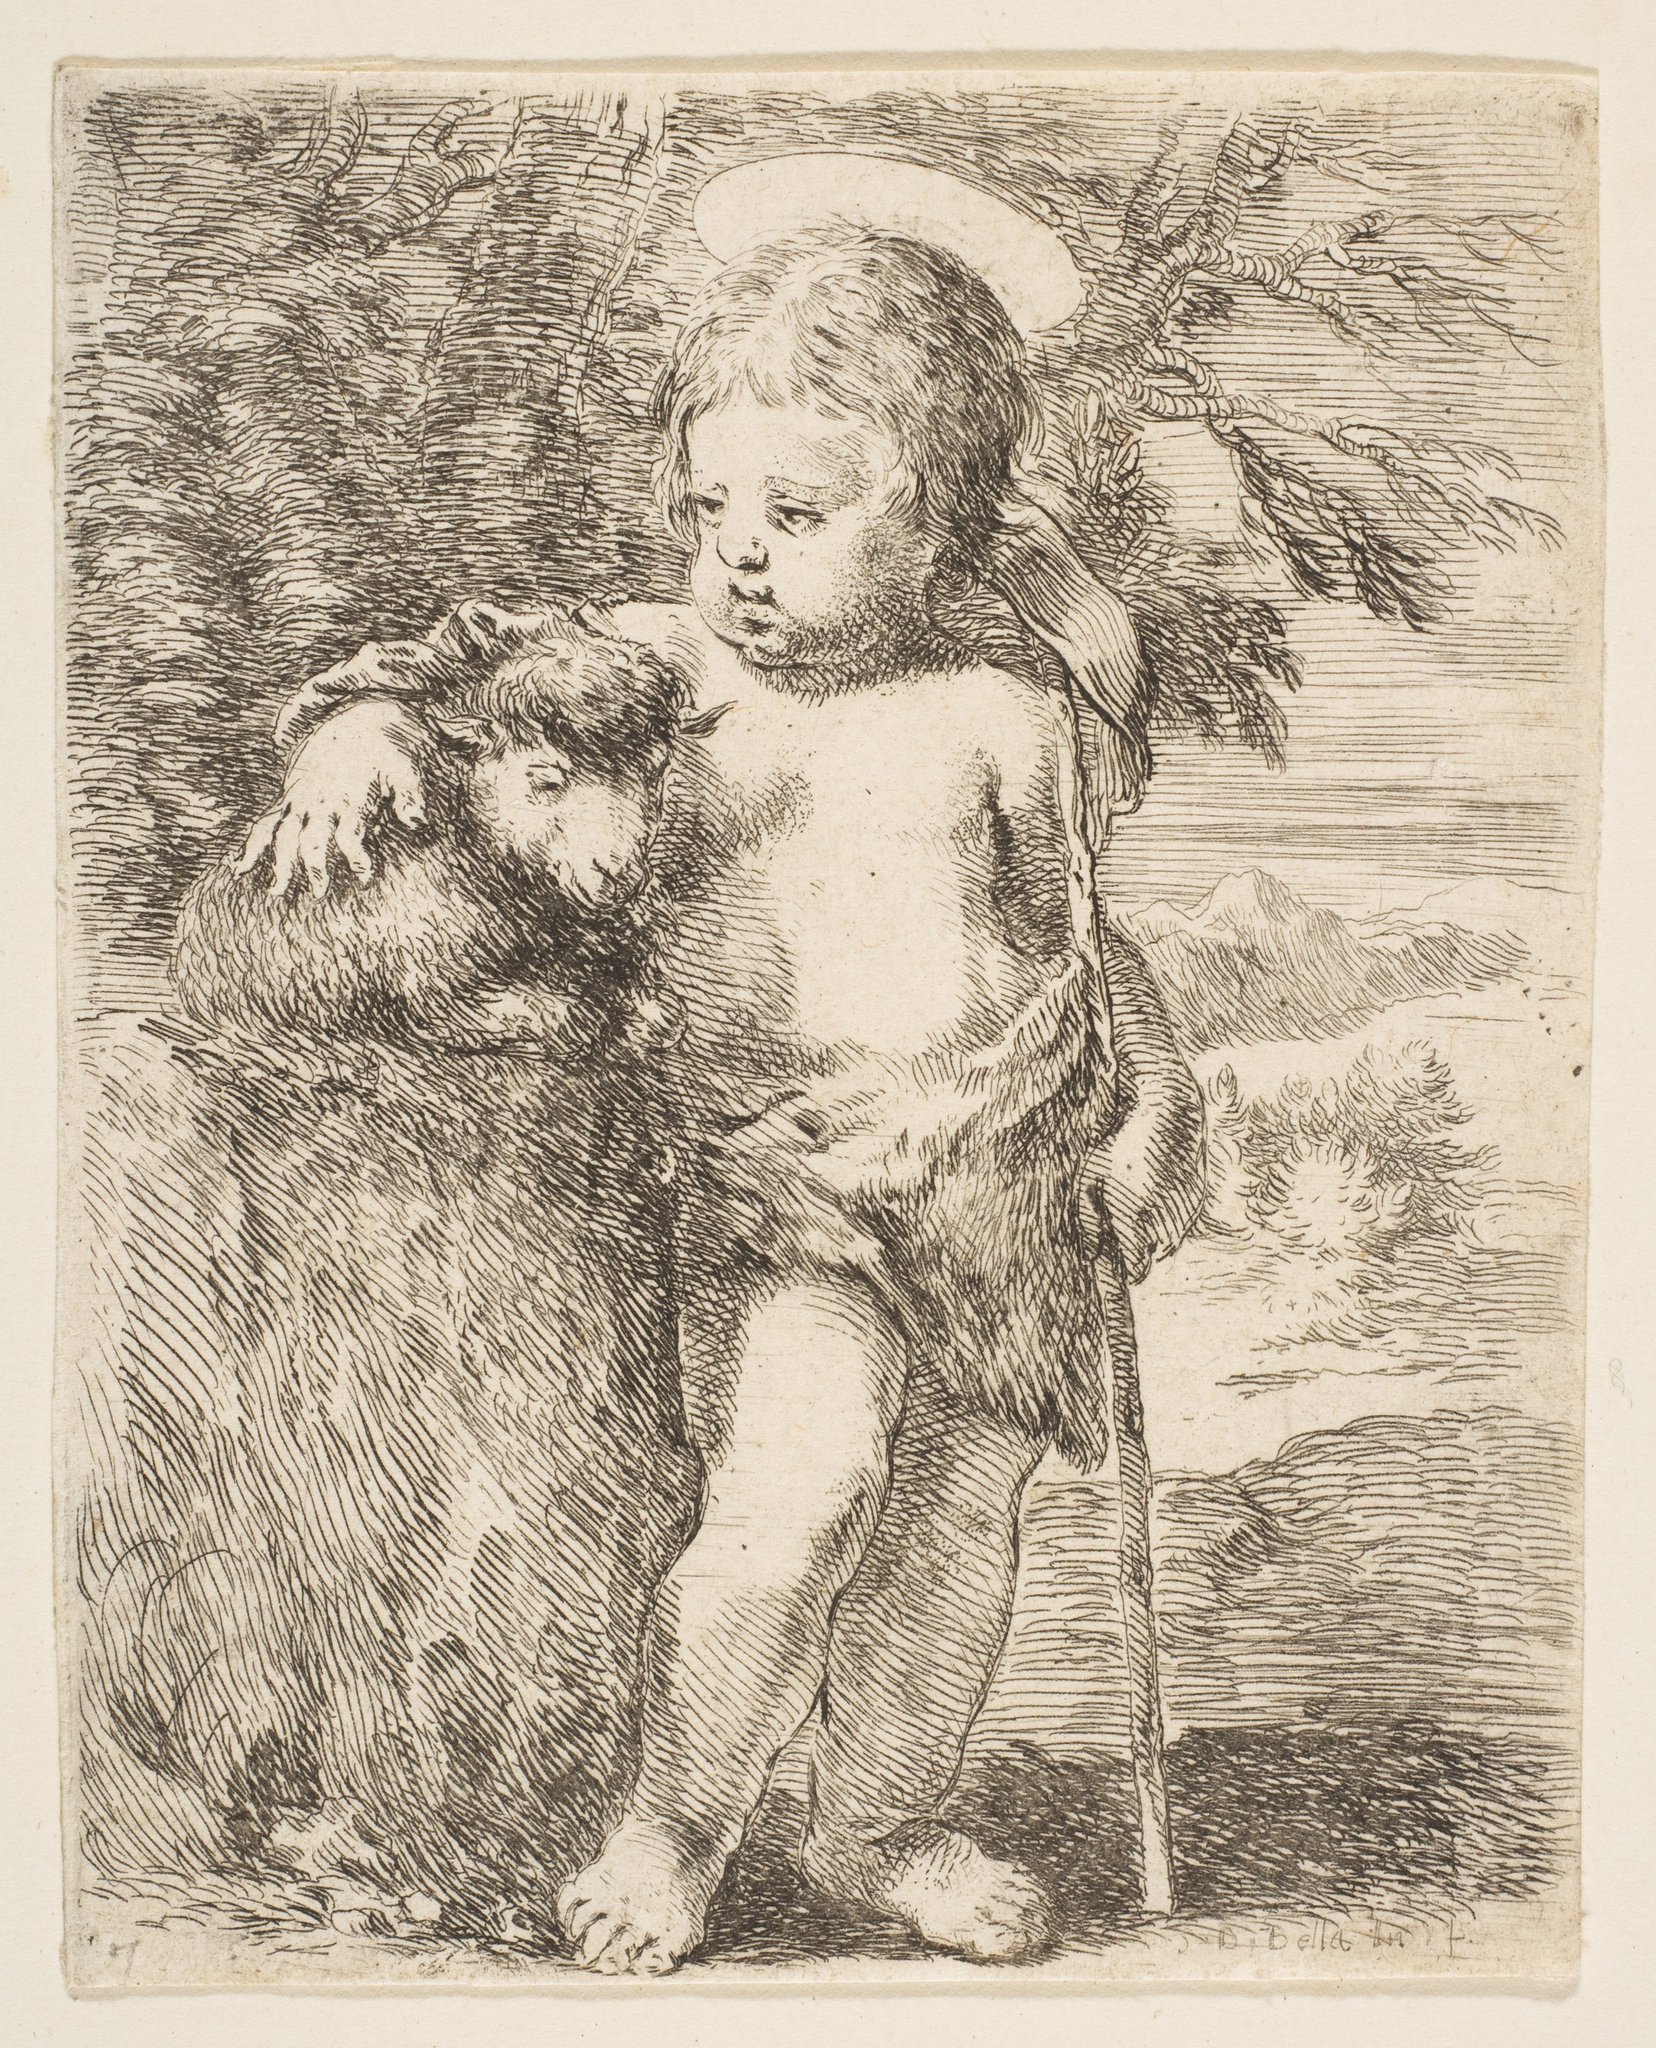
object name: print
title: The Infant St. John the Baptist with his Lamb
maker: stefano della bella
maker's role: artist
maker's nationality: italian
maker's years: 1610-1664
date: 1649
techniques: etching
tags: infants,lambs,saint john the baptist